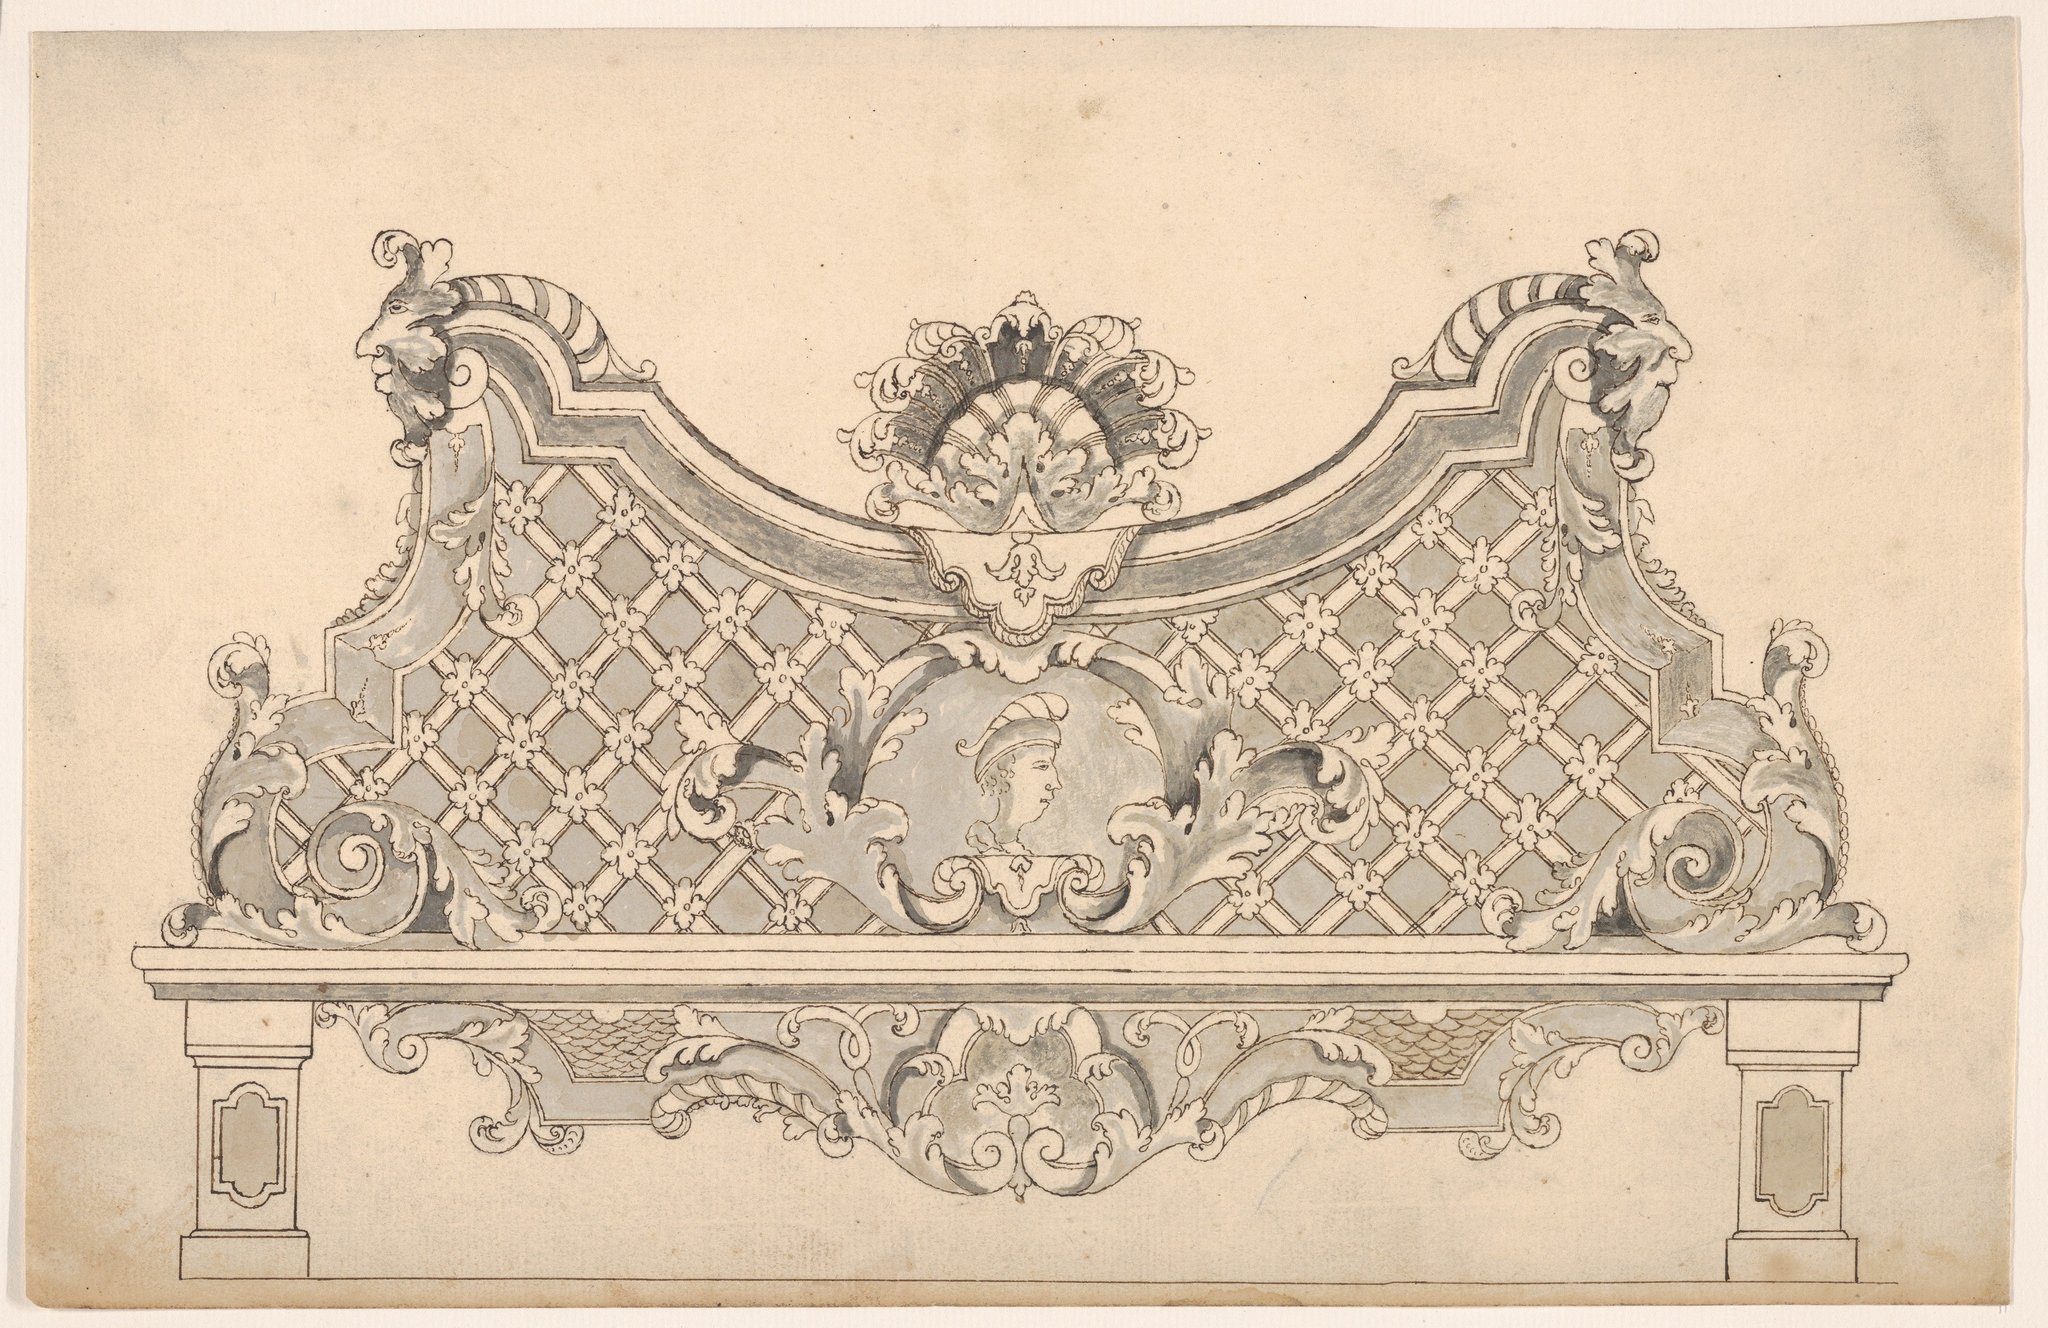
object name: drawing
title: Design for a Wooden Bench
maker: anonymous, 18th century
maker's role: artist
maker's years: 1700-1800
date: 1700-1730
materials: ink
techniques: pen, wash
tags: benches